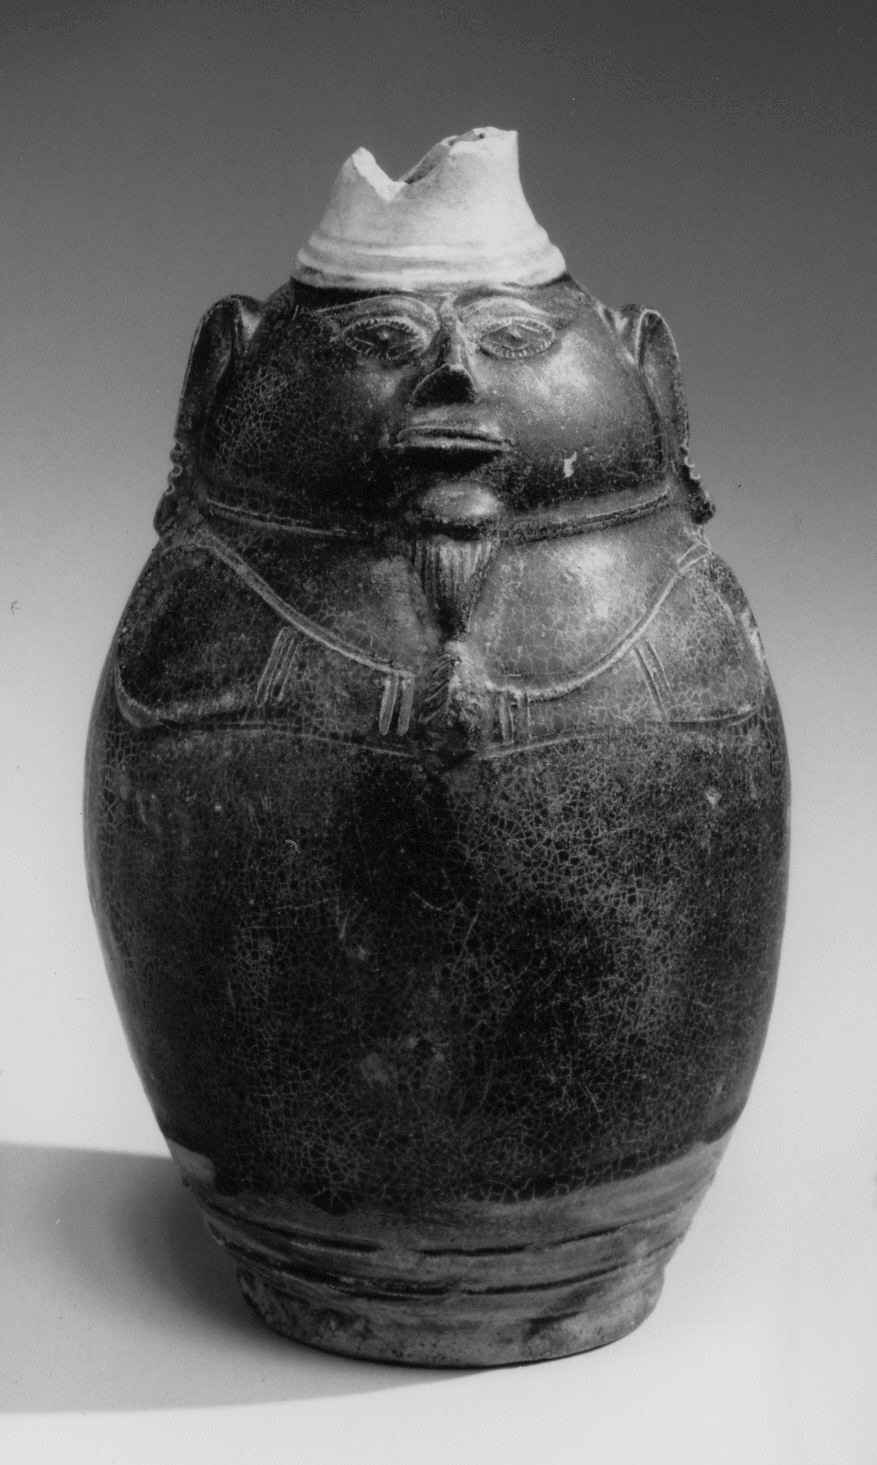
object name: bottle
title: Anthropomorphic Bottle in Human Form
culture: thai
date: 1001-1100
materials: stoneware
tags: faces